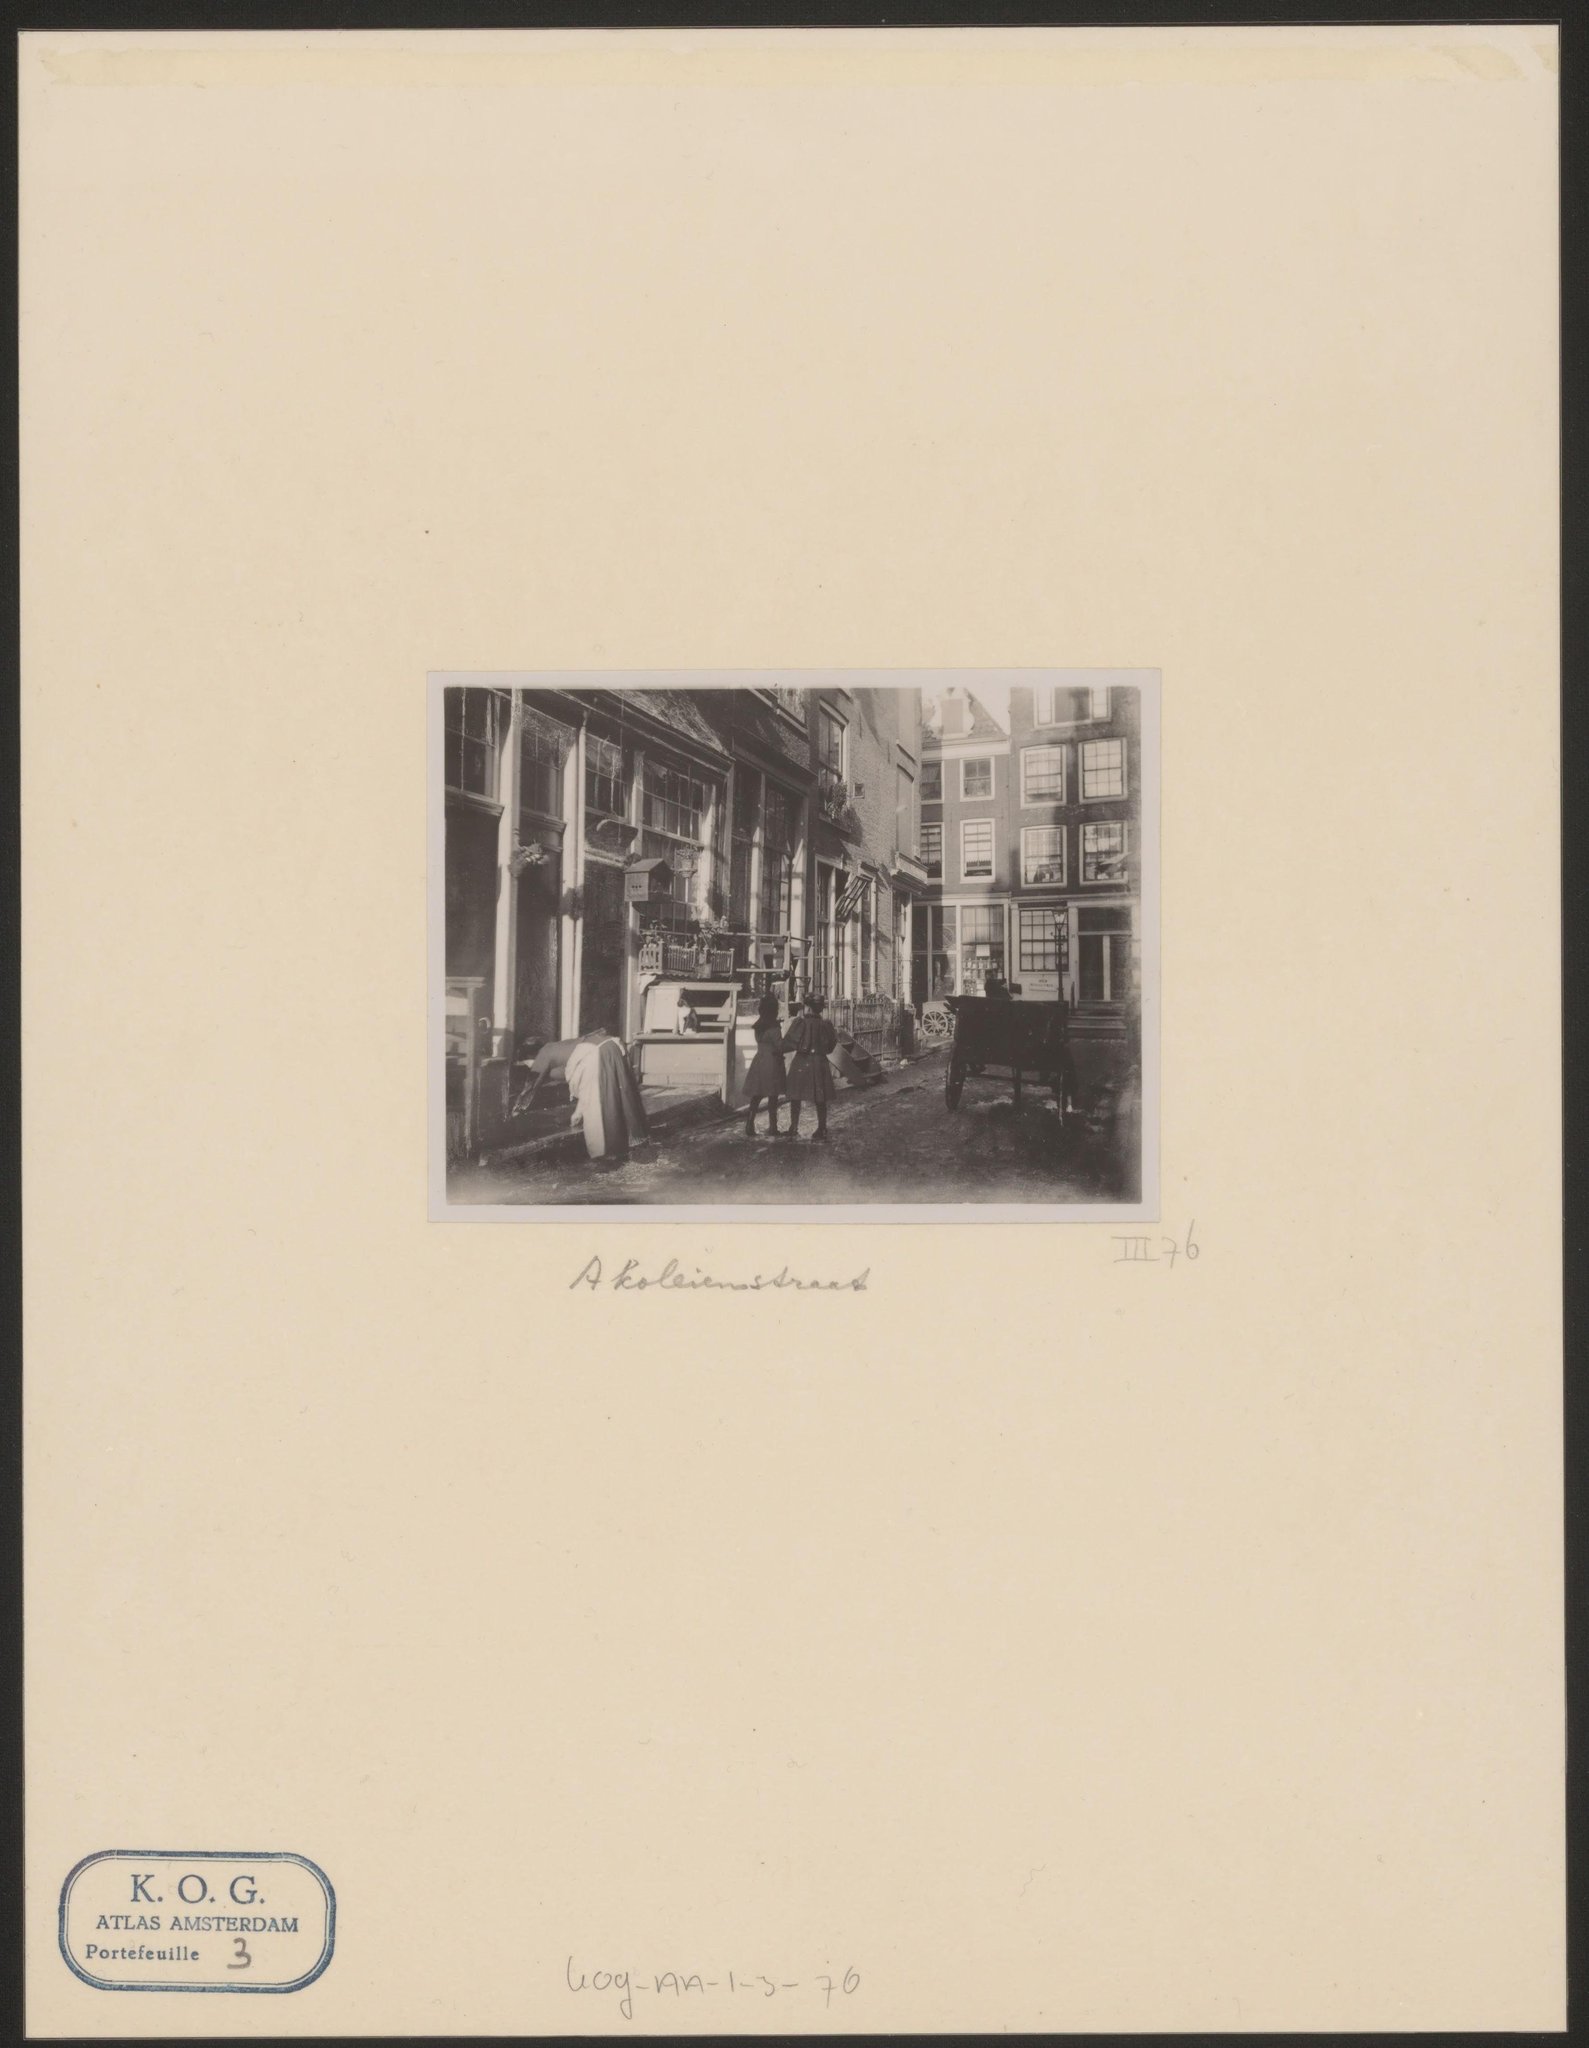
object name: photograph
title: Gezicht op de Akoleienstraat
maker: Anonymous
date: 1880-1950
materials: paper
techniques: gelatin silver print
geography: amsterdam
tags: city-view in general; 'veduta', the usual house or row of houses, street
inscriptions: inscription: ‘Akoleienstraat’, collector's mark: ‘3’ Lugt 1641b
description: Onderwerpsrubriek binnen de Atlas Amsterdam: Achterburgwal, Nieuwezijds en - Oudezijds; Nieuwe Achtergracht, Achterweg, Akoleienstraat.